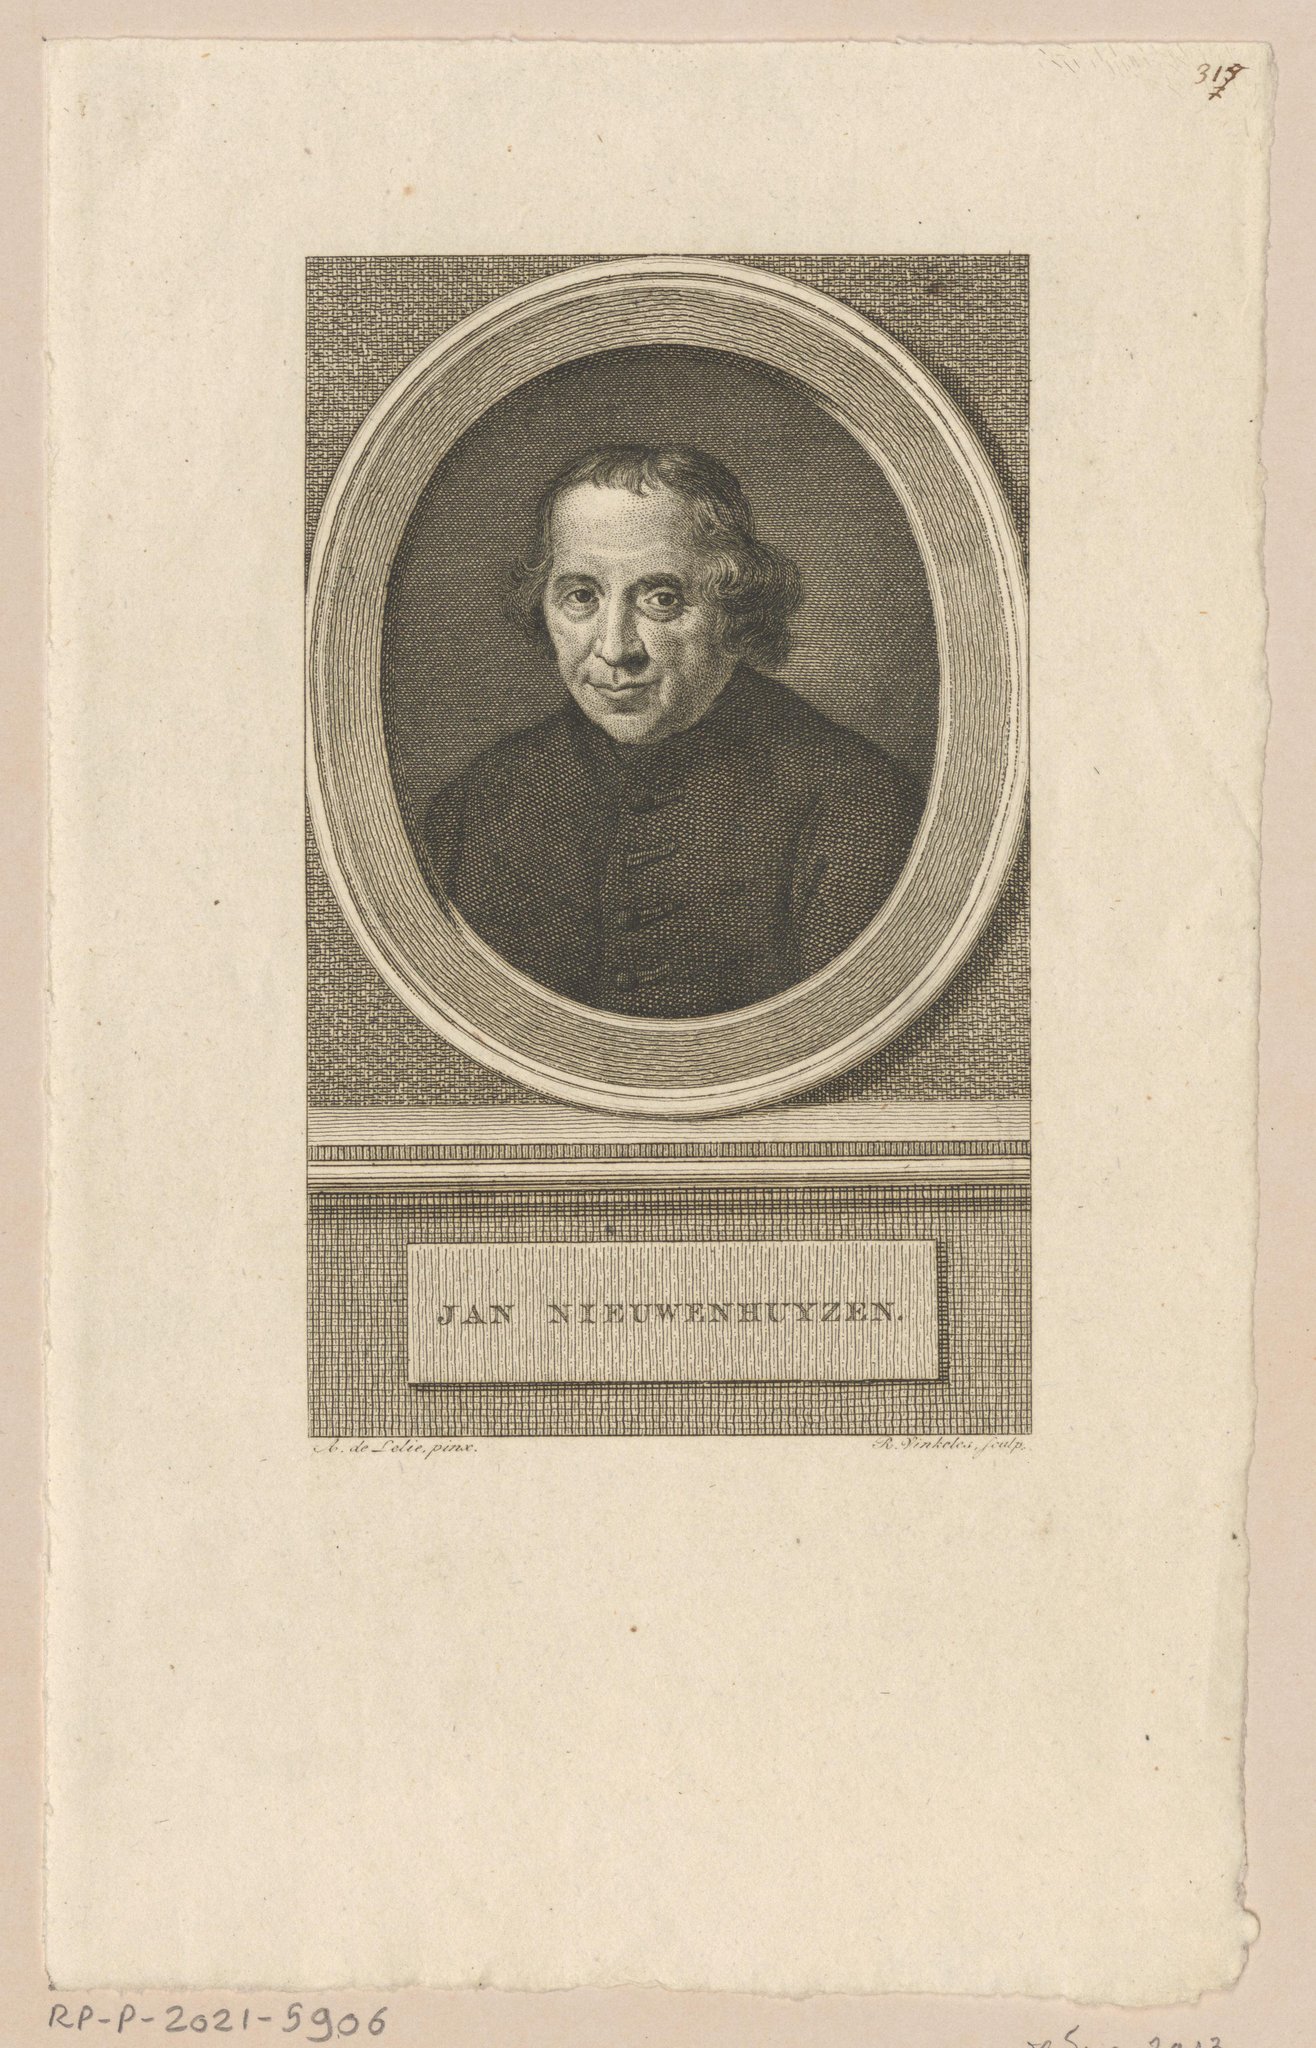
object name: print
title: Portret van Jan Nieuwenhuyzen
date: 1786-1809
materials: paper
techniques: etching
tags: amsterdam, jan nieuwenhuyzen, historical persons, functionaries and dignitaries ~ protestant churches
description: Prent mogelijk uit: Wagenaar, Jan. Vaderlandsche historie, (...) ten vervolge van Wagenaars Vaderlandsche historie. 43 dln. Amsterdam: Johannes Allart, 1786-1809.